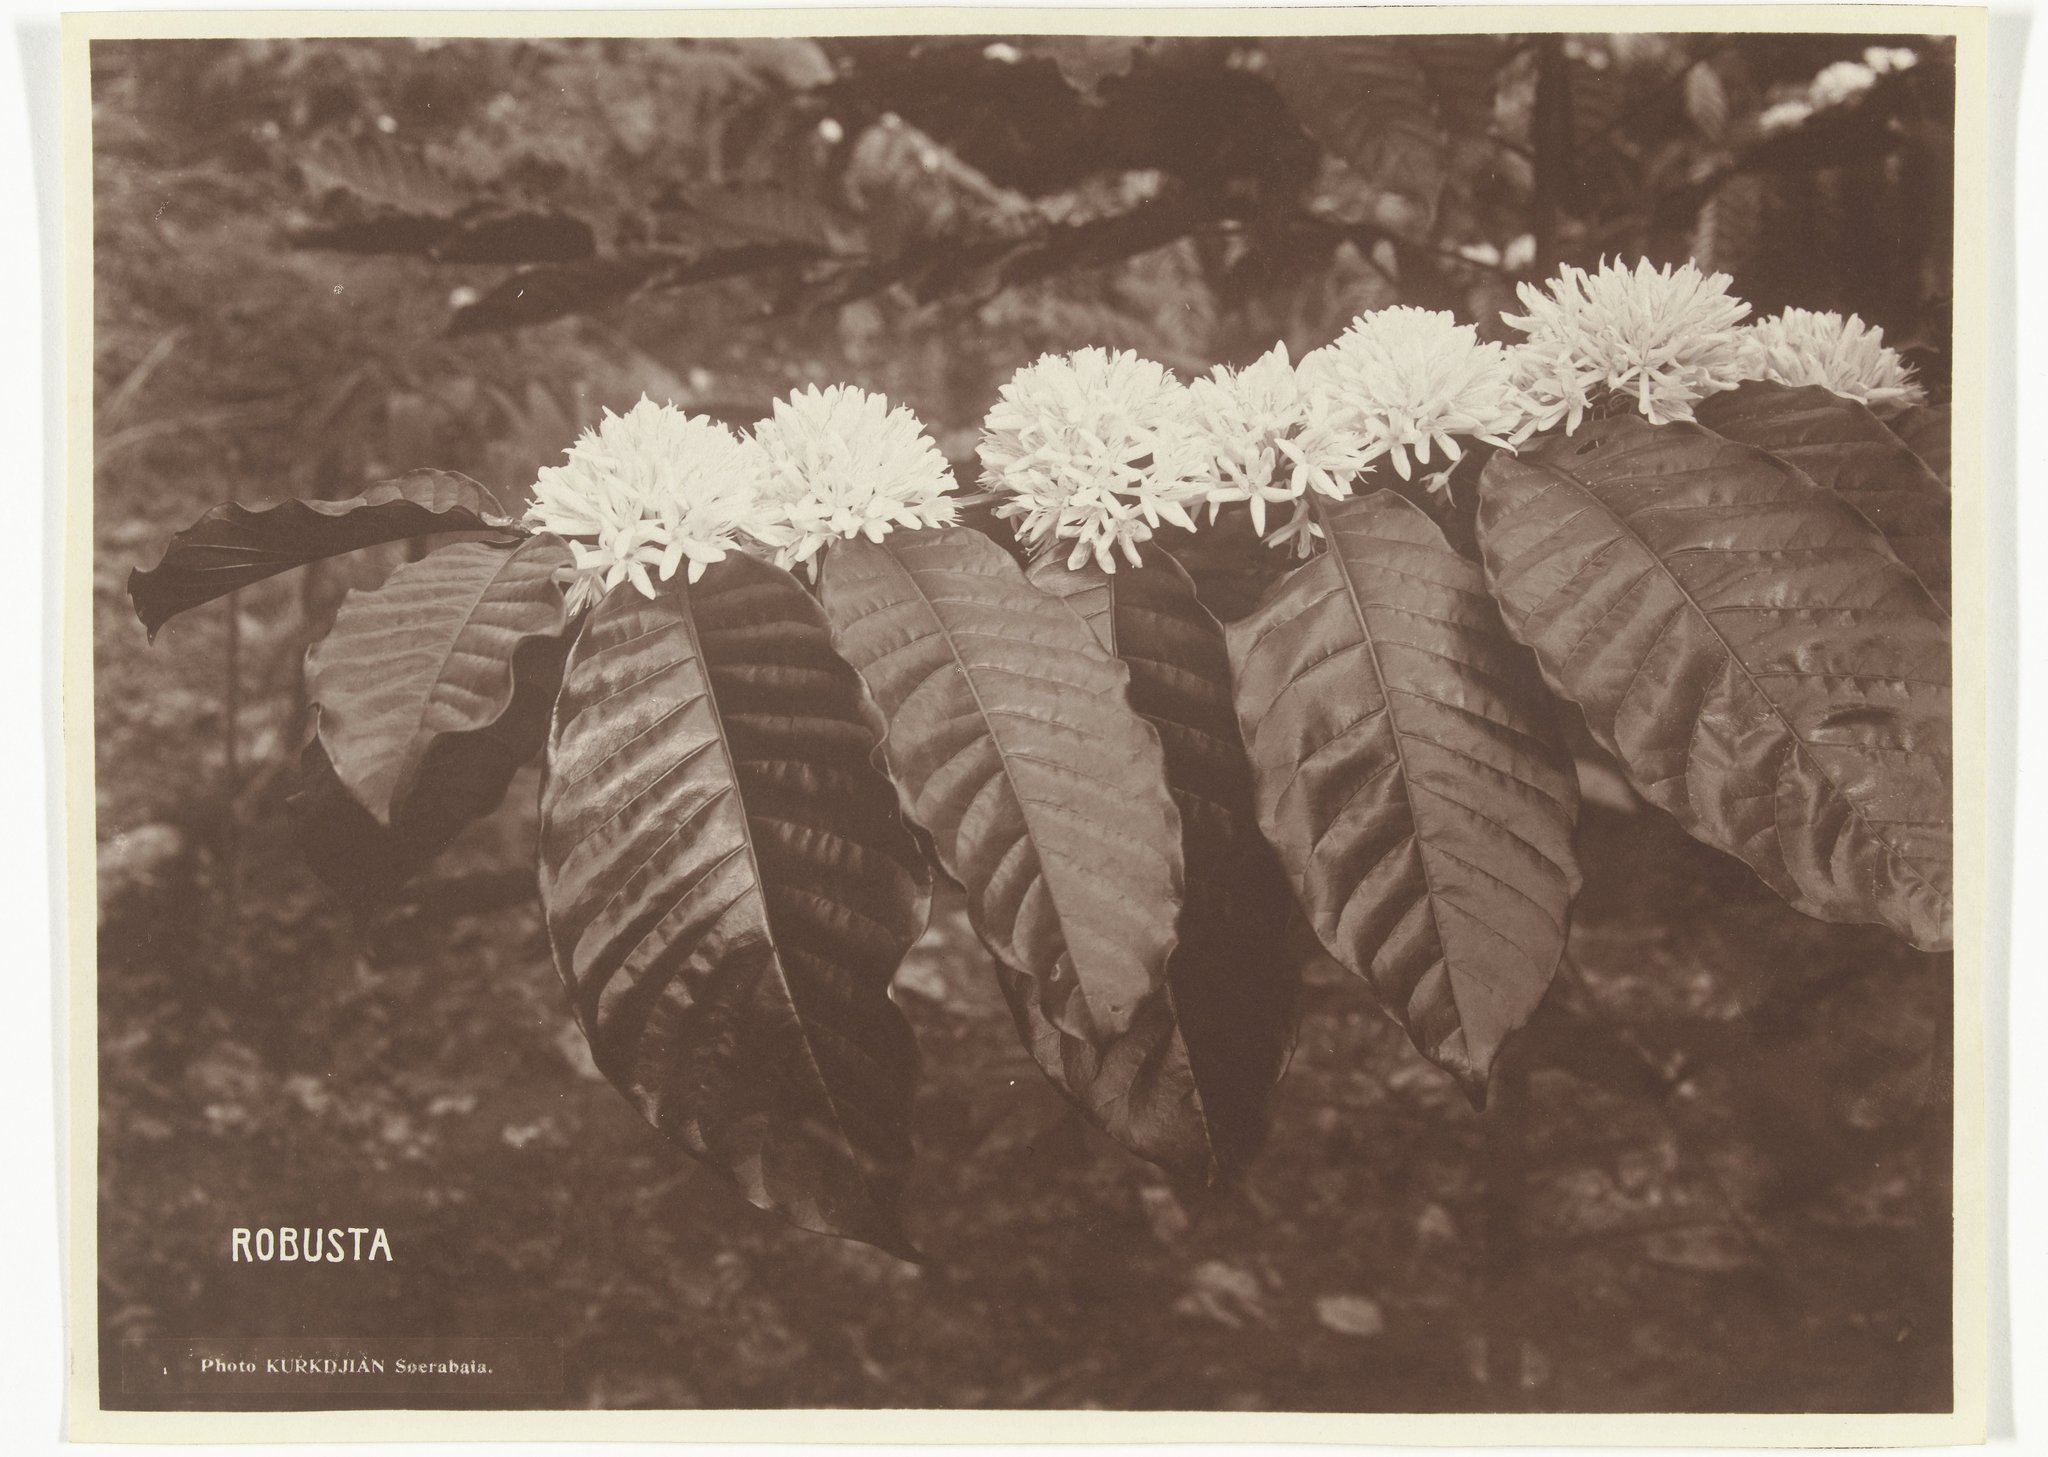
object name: photograph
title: Bloeiende koffieplant (Robusta), voormalig Nederlands-Indië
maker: onnes kurkdjian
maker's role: fotograaf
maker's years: 1851-1903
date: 1890-1911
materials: paper, photographic support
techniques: gelatin silver print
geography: surabaya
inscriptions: name: ‘Photo Kurkdjian Soerabia’, name: ‘Robusta’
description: Bloeiende koffieplant (Robusta), voormalig Nederlands-Indië